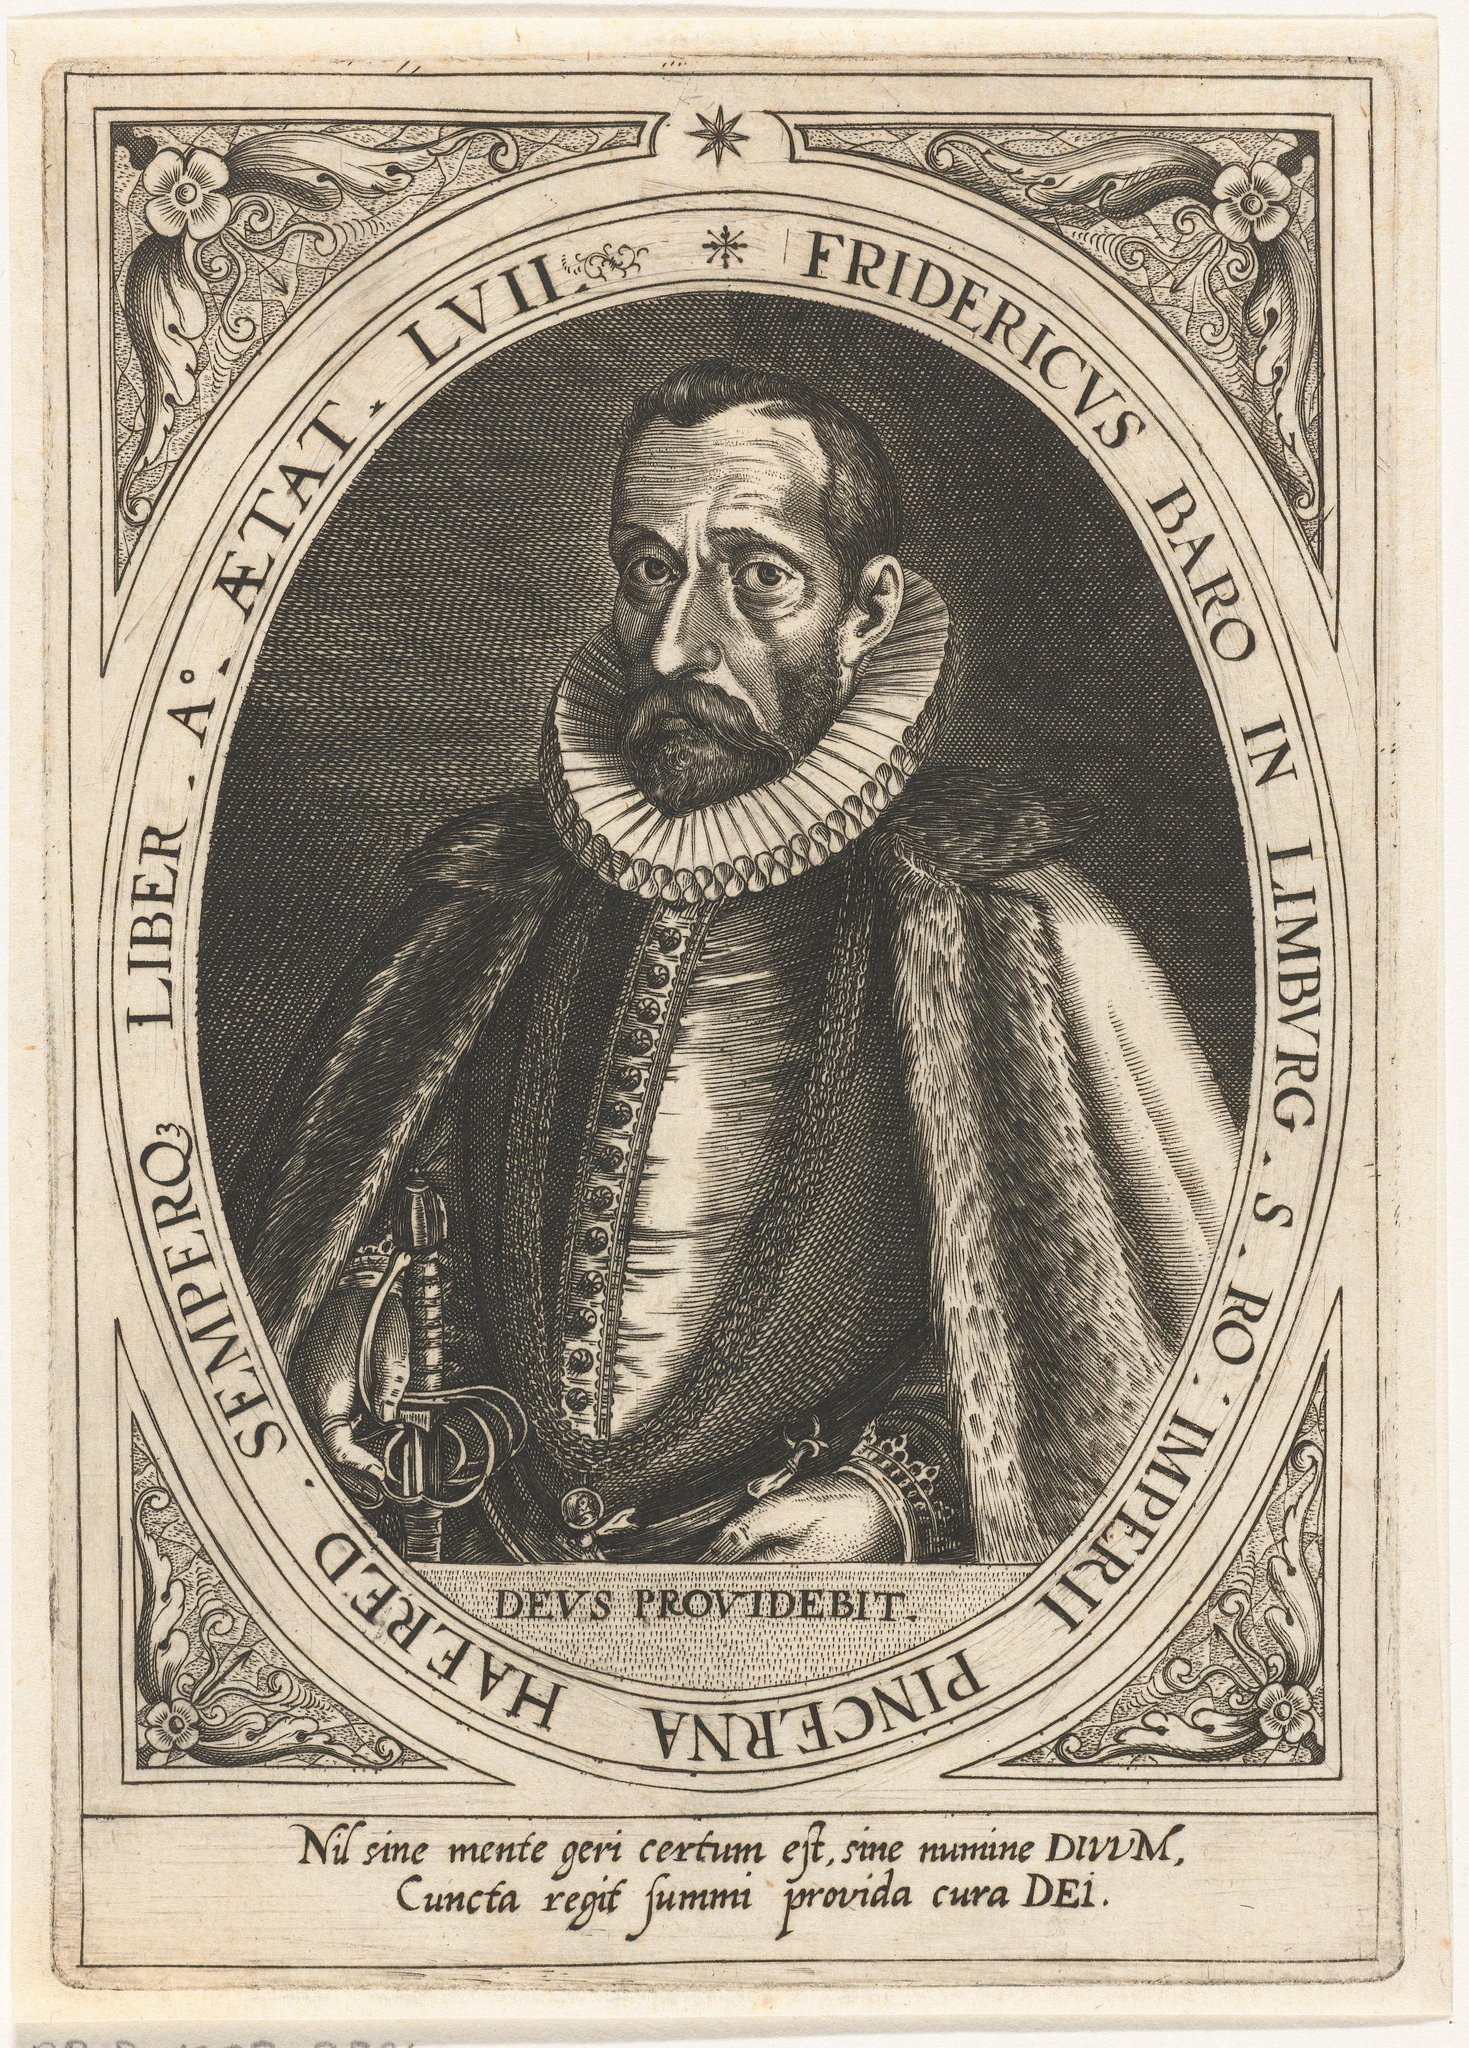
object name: print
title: Portret van Frederik baron van Limburg op 57-jarige leeftijd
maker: dominicus custos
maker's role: print maker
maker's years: 1560-1615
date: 1600-1604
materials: paper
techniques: engraving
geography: augsburg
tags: frederik (baron van limburg)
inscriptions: collector's mark: Lugt 2228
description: Illustratie uit: D. Custos en M. Henning. Atrium heroicum Caesarum, regum aliorq. summatum ac procerum qui intra proximum seculum vixere, aut hodie supersunt, imaginib. Deel 1-4. Augsburg: D. Custos, 1600-1604.